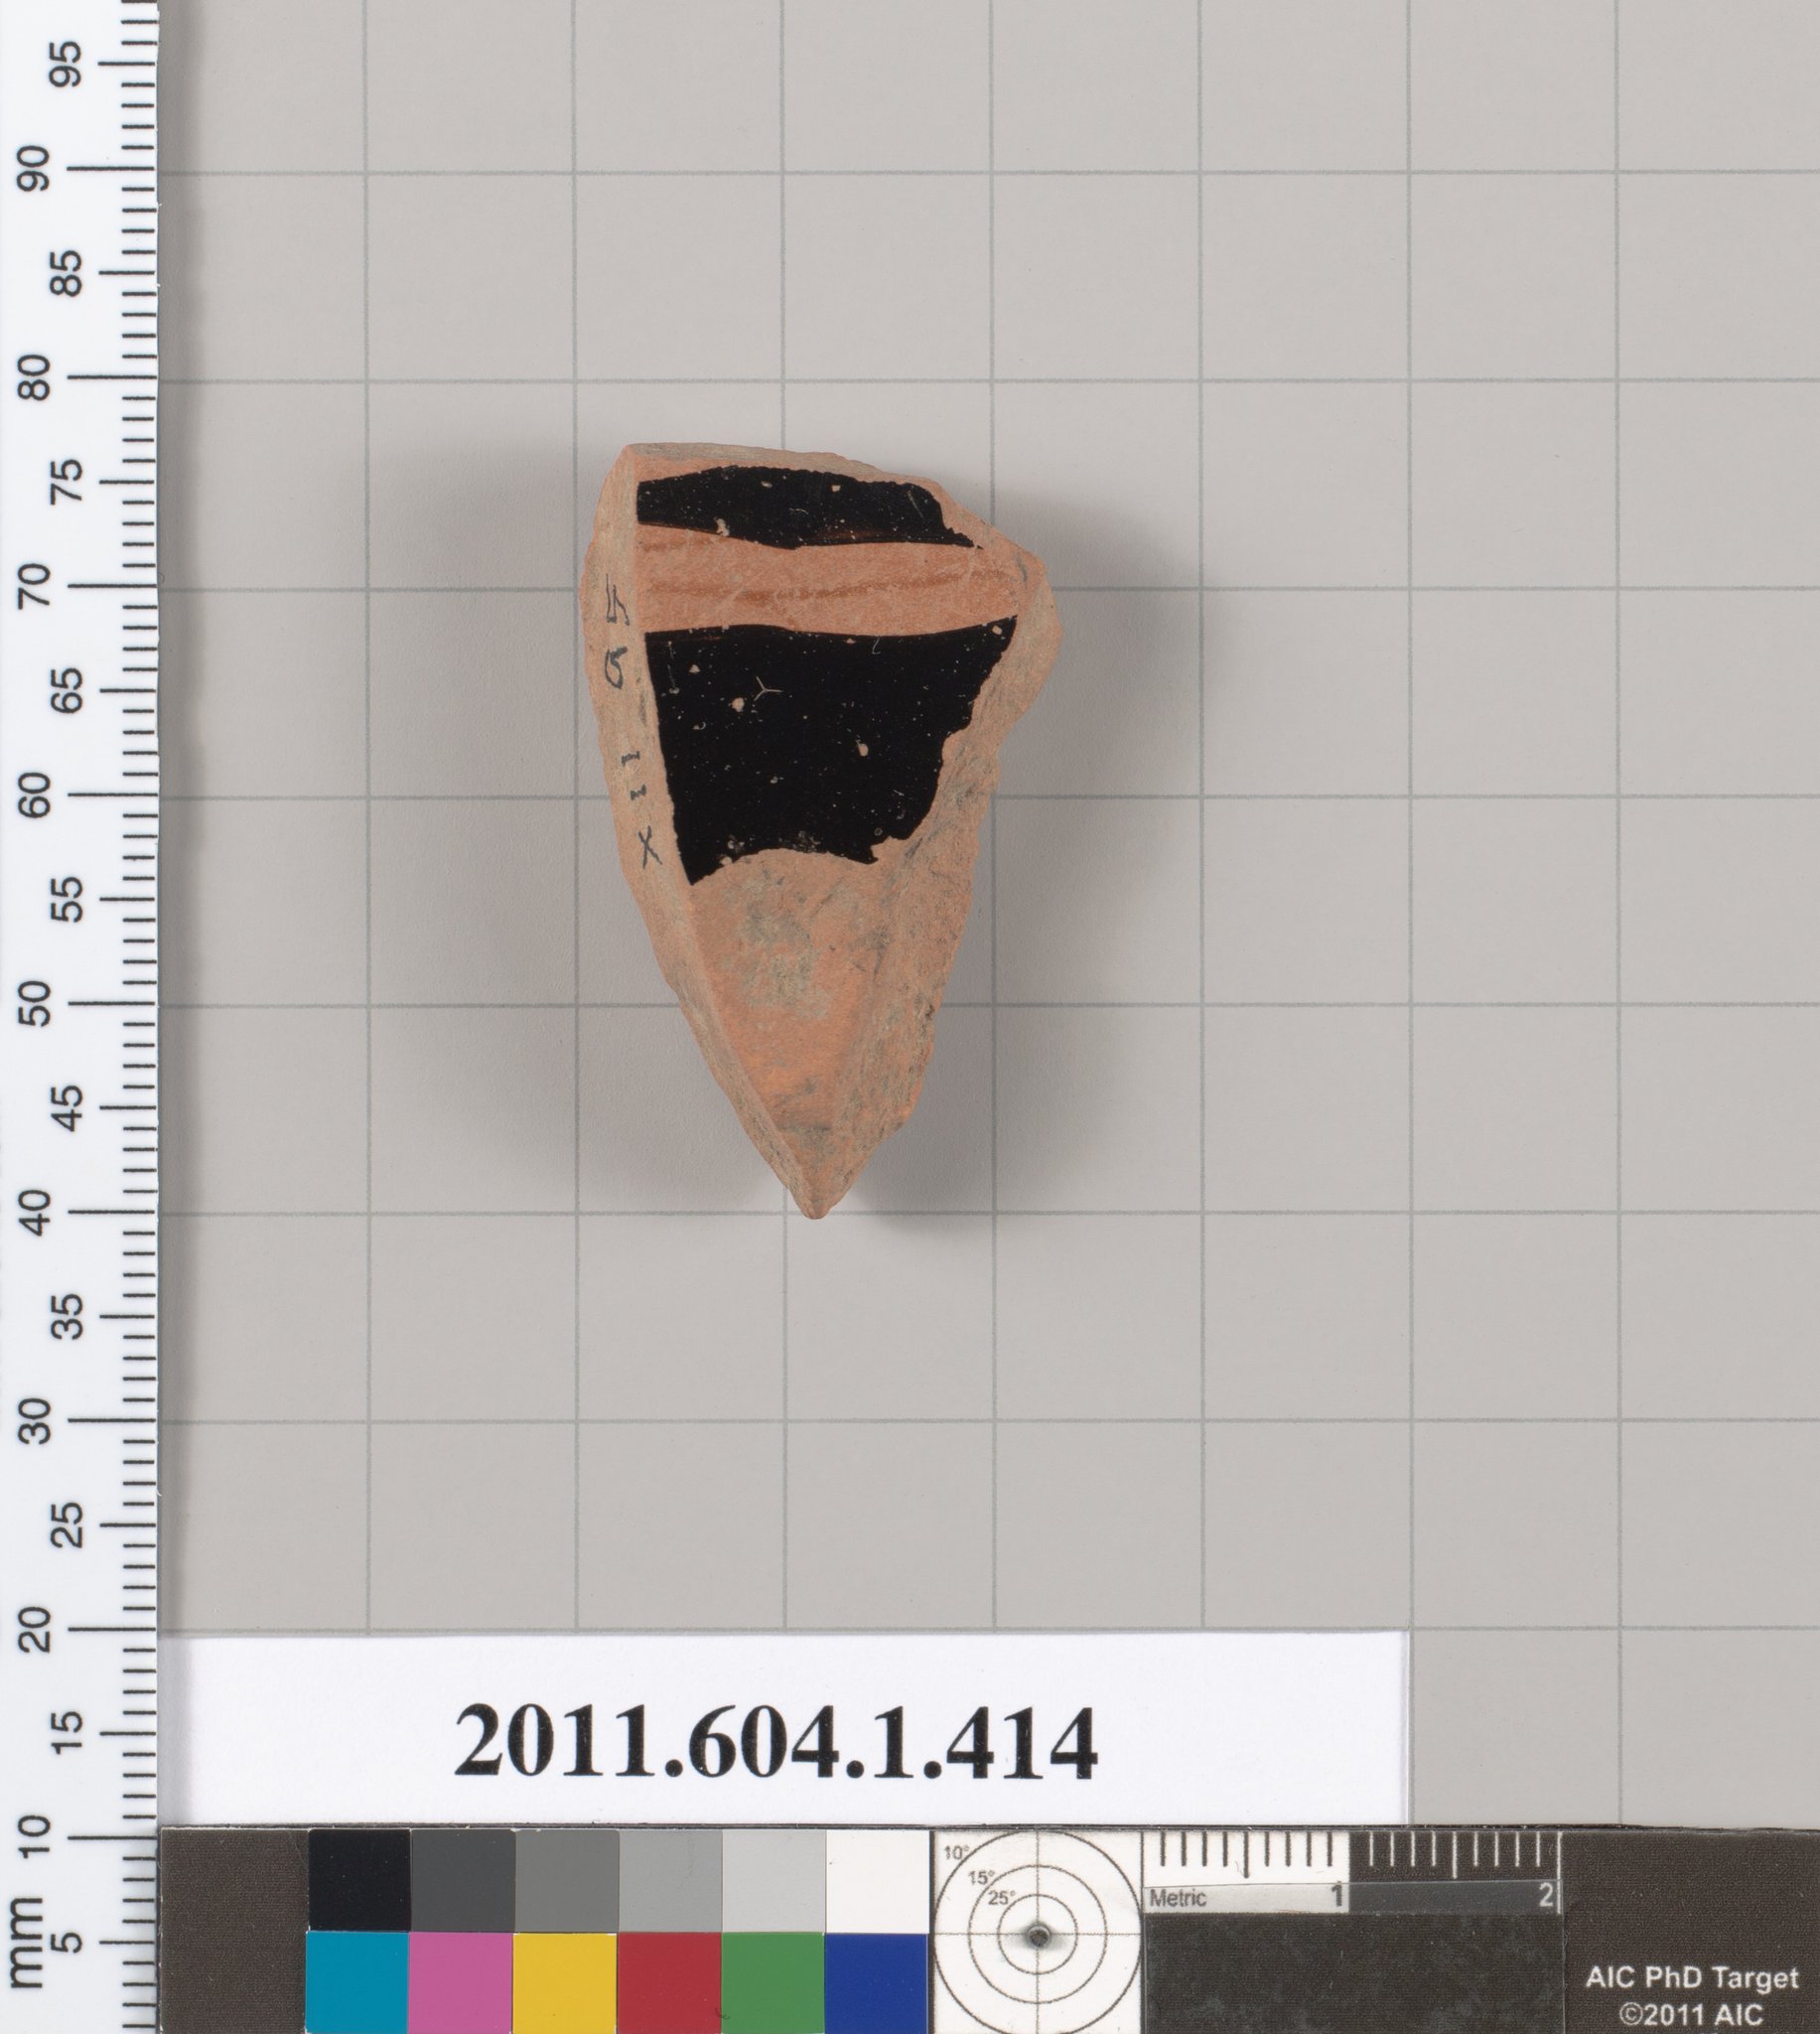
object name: kylix fragment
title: Terracotta fragment of a kylix (drinking cup)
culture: greek, attic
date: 475-451 BCE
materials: terracotta